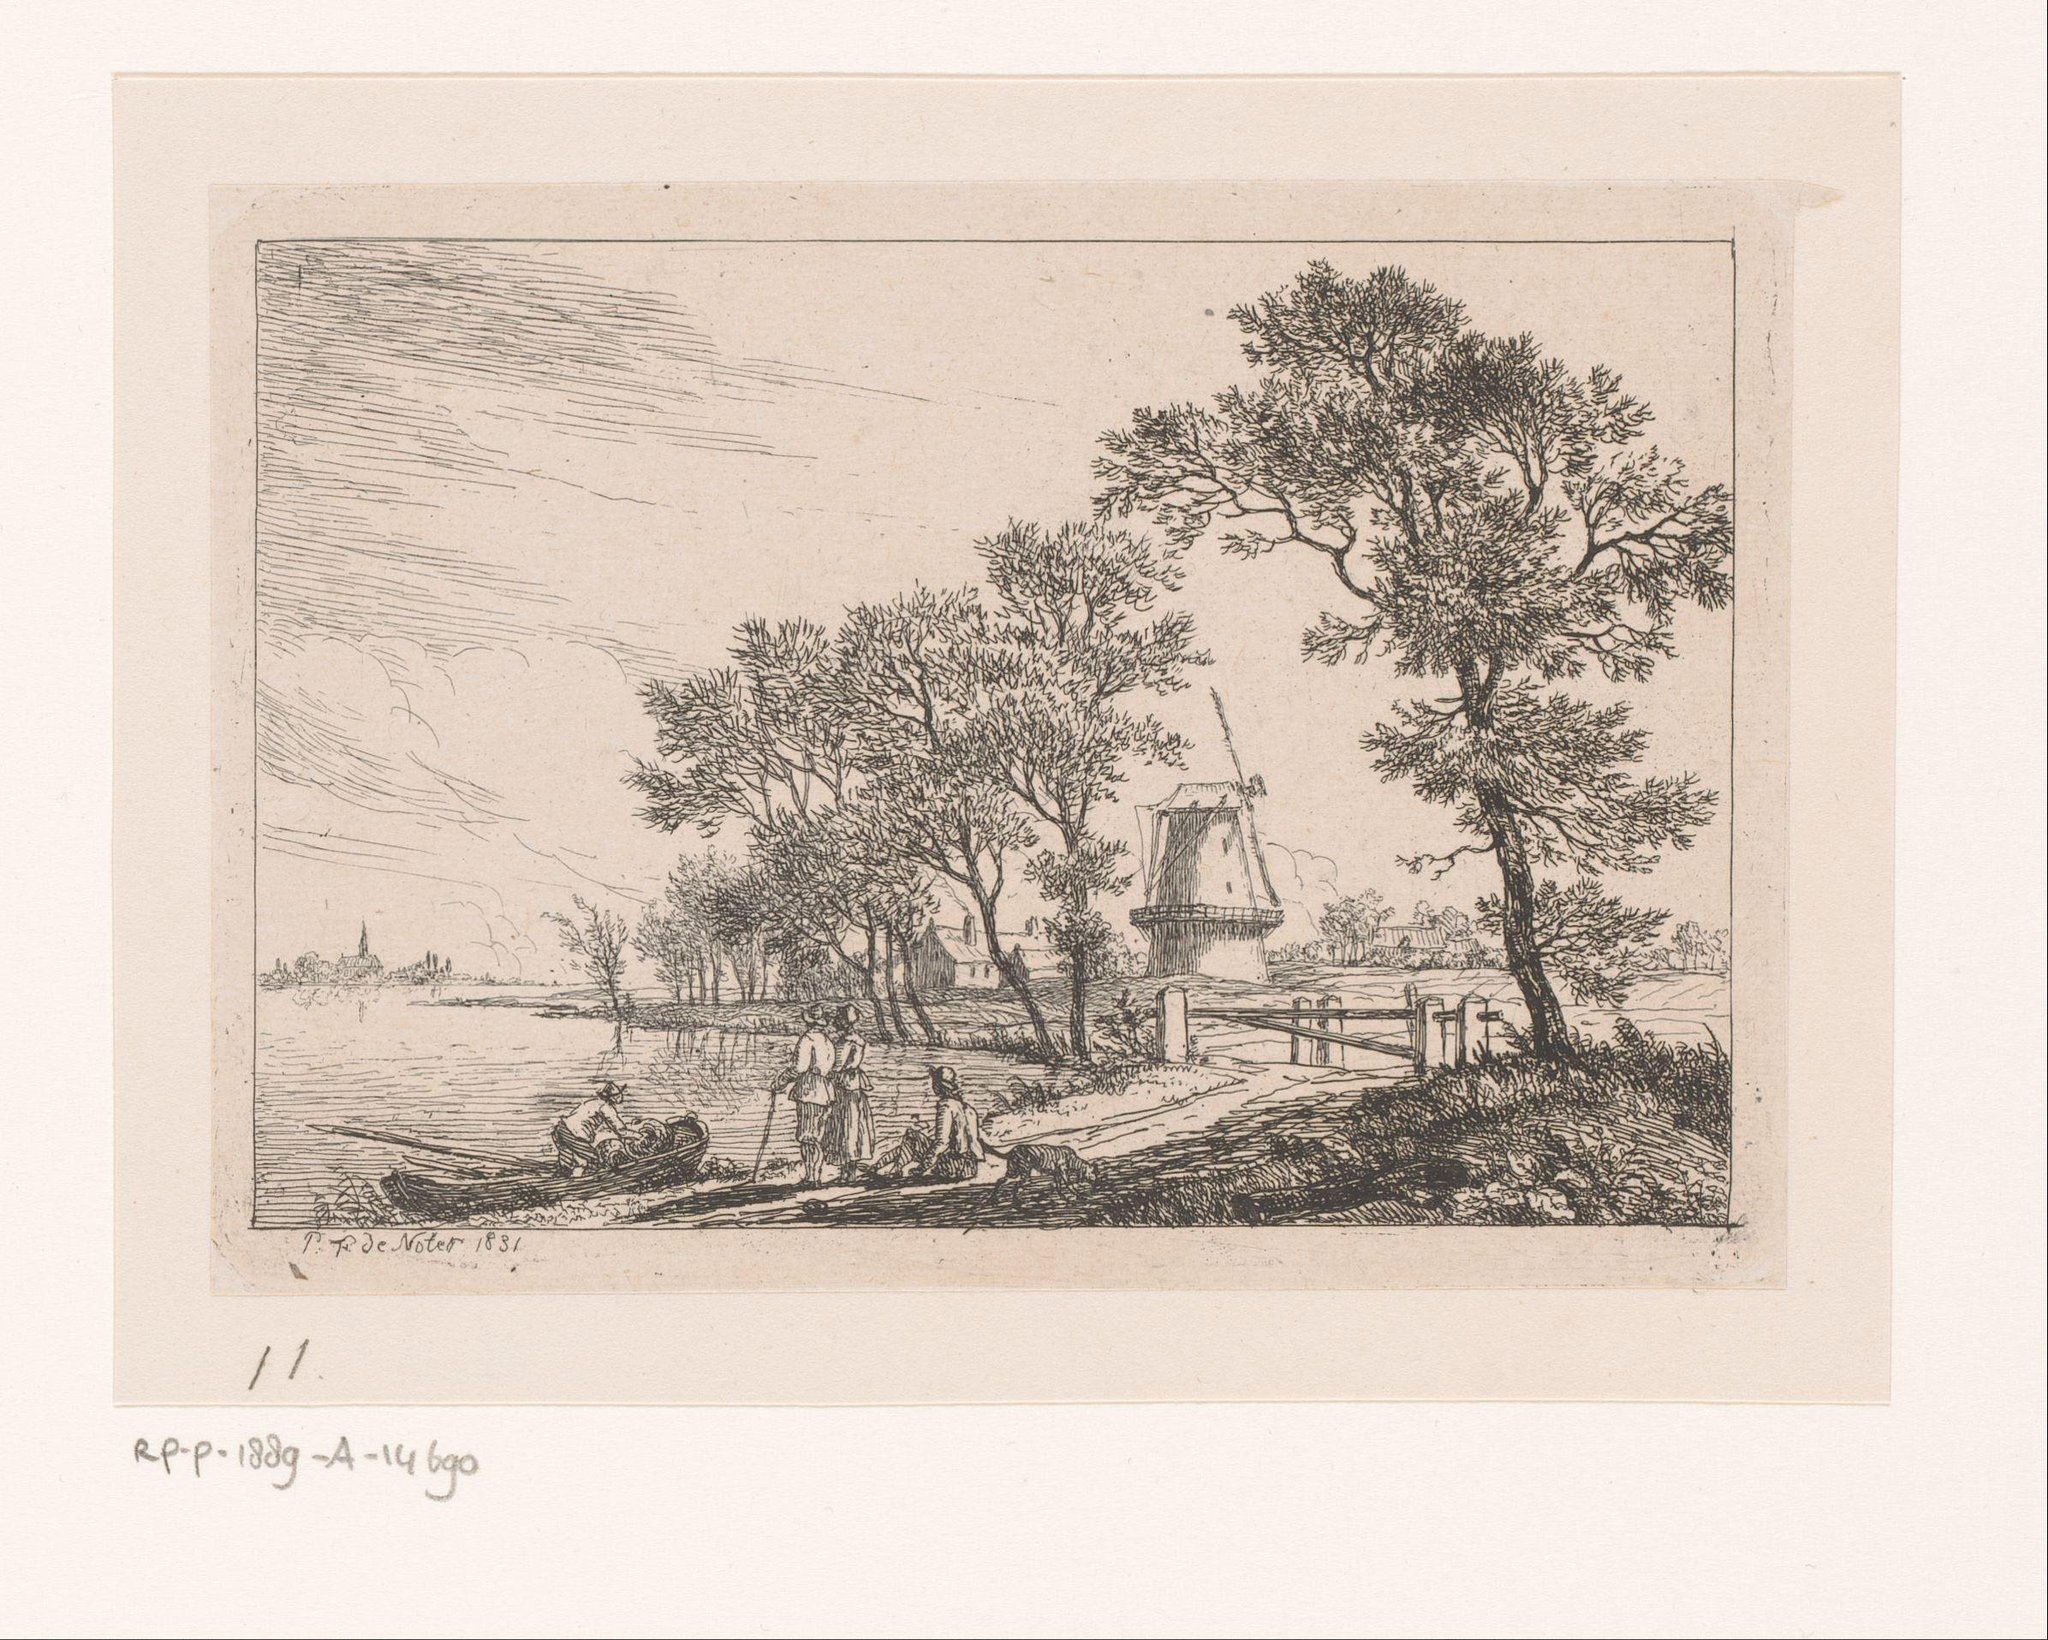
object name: print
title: Landschap met figuren langs een oever en een windmolen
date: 1831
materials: paper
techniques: etching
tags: landscapes with waters, waterscapes, seascapes (in the temperate zone), rowing-boat, canoe, etc., windmill in landscape (+ city(-scape) with figures, staffage)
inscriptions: collector's mark: Lugt 2228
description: Prent behoort mogelijk tot de prentserie: Recueil de Gravures à l'eau forte, dont plusieurs d'apres Hobbema, par P.F. de Noter. Gent: s.n., 1831.